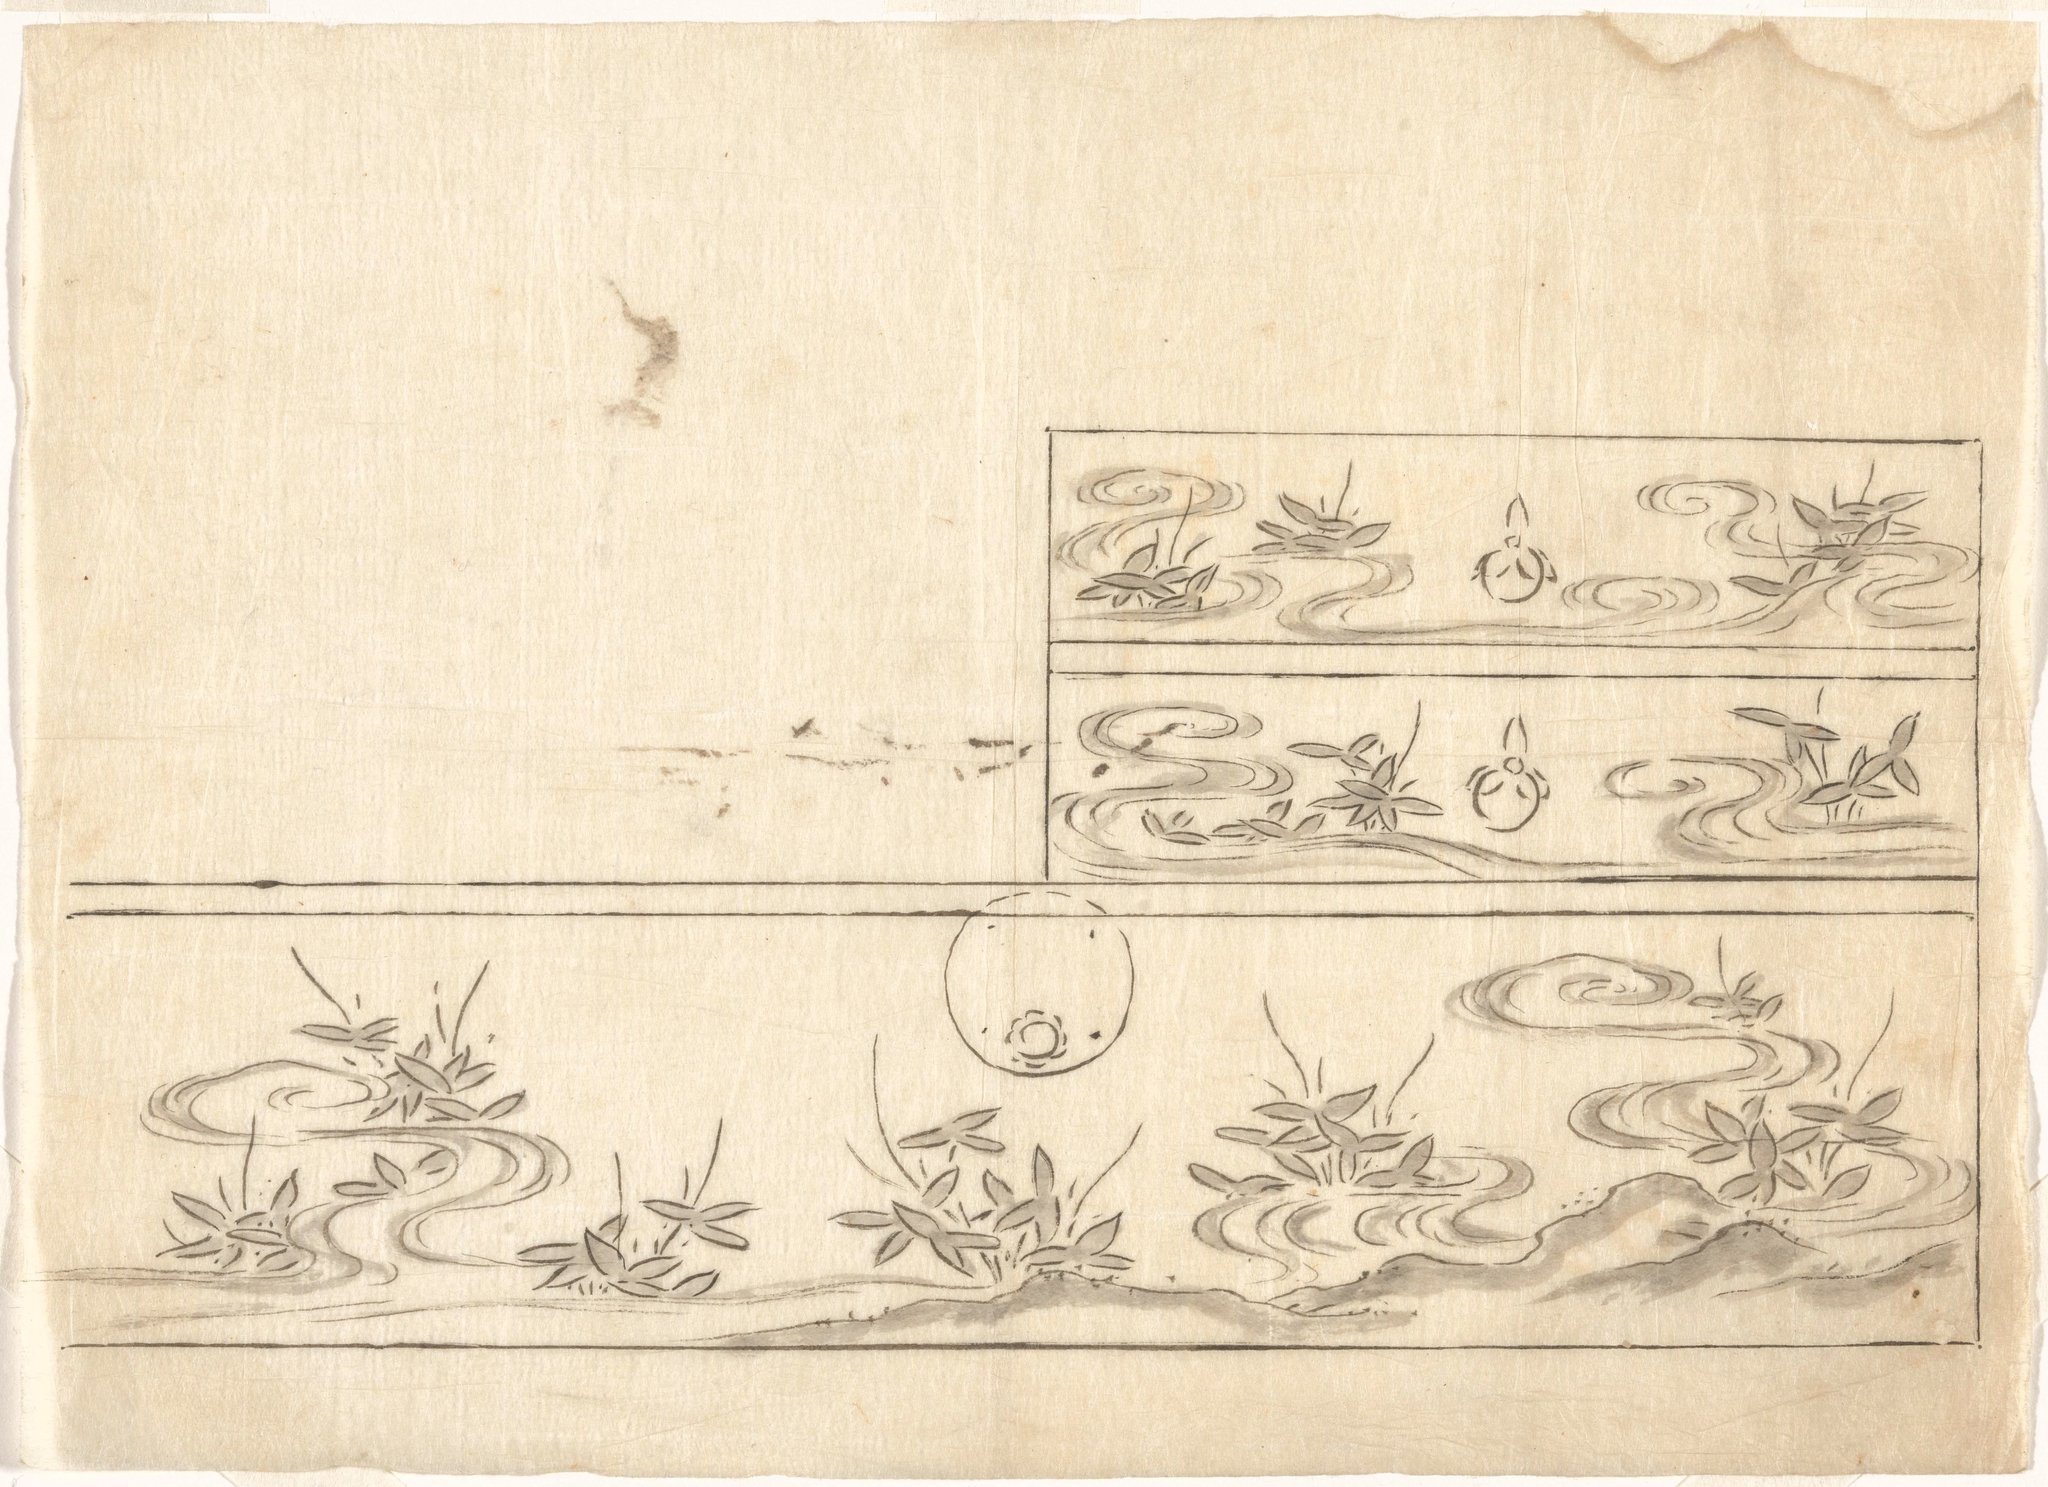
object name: design drawing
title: Ontwerp voor lakwerklades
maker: sasaya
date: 1800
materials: ink, paint, paper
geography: kyoto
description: Ontwerptekening voor drie lakwerklades met pijlkruid- en watermotief.